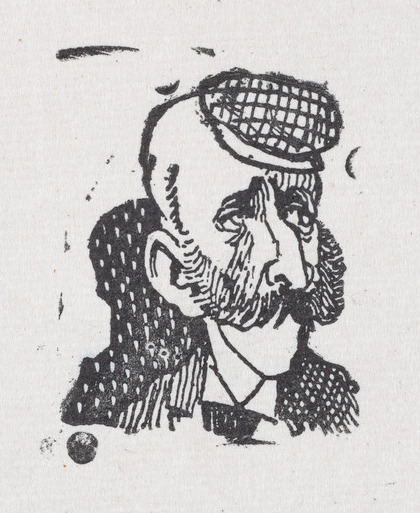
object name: print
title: Head of a bearded man wearing a checkered cap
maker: josé guadalupe posada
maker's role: artist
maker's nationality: mexican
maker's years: 1852-1913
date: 1880-1910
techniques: woodcut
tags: men